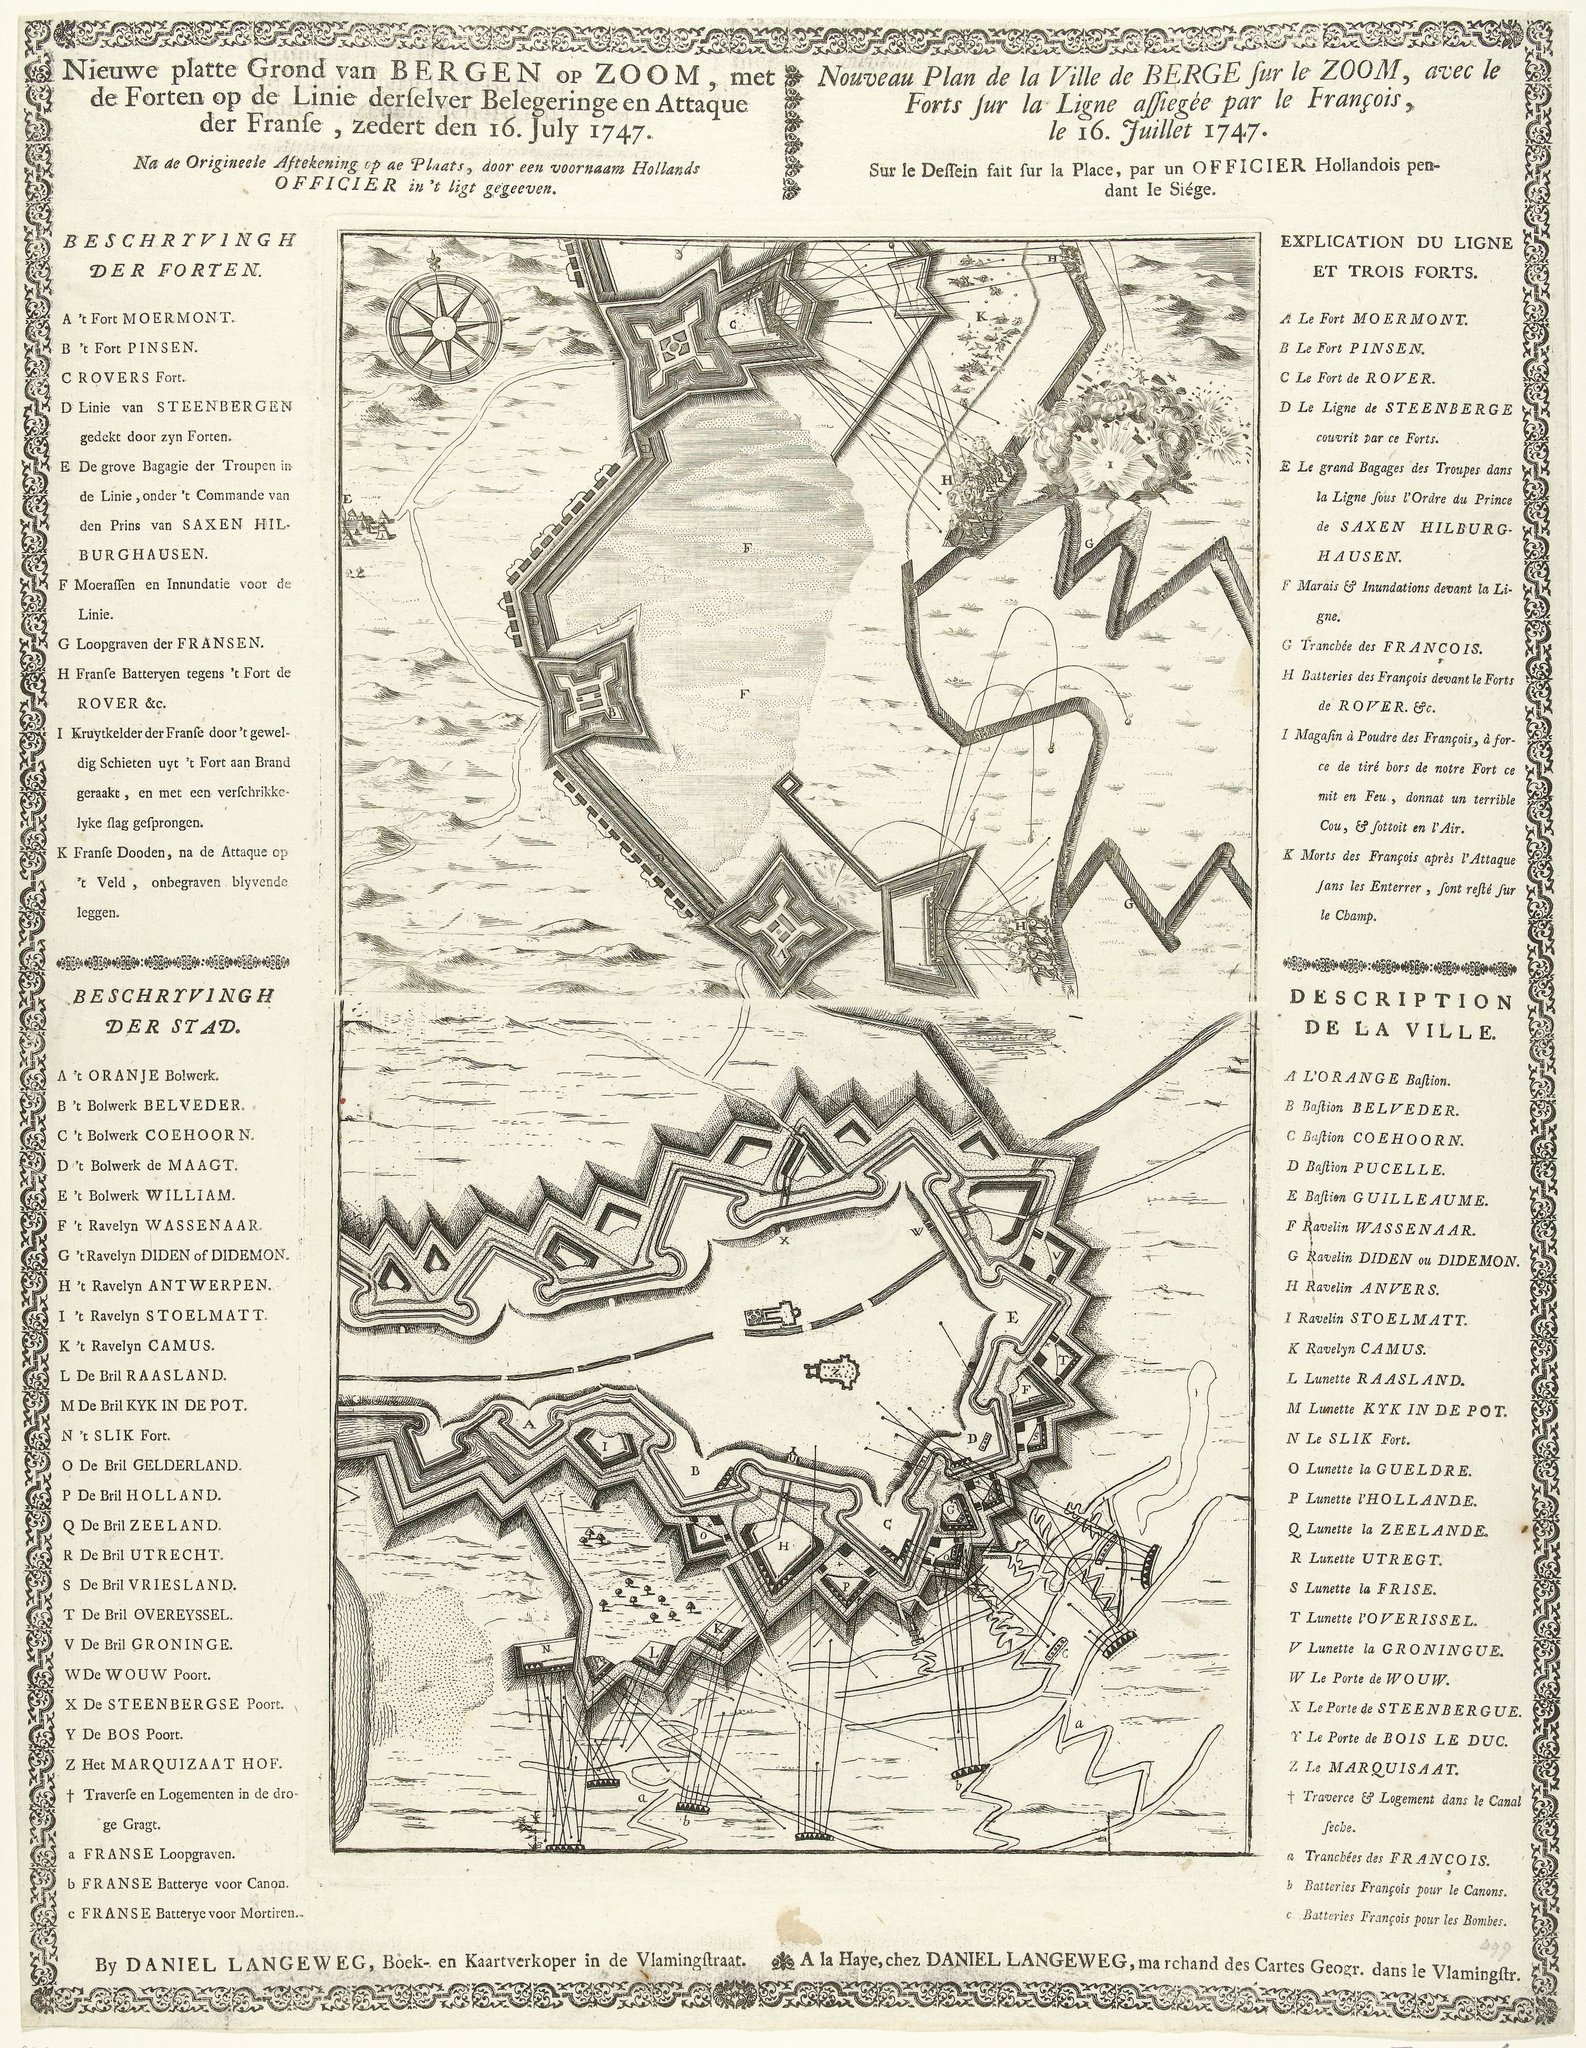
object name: map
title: Plattegrond van het beleg van Bergen op Zoom, 1747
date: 1747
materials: paper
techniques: engraving, etching, letterpress printing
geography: northern netherlands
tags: maps of separate countries or regions, siege, position war, bergen op zoom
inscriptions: collector's mark: Lugt 2228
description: Plattegrond van het beleg van Bergen op Zoom door de Fransen, aangevangen op 12 juli 1747. Kaart gedrukt van twee platen met aan weerszijden de legenda's in het Nederlands en Frans, het geheel in een decoratieve rand.